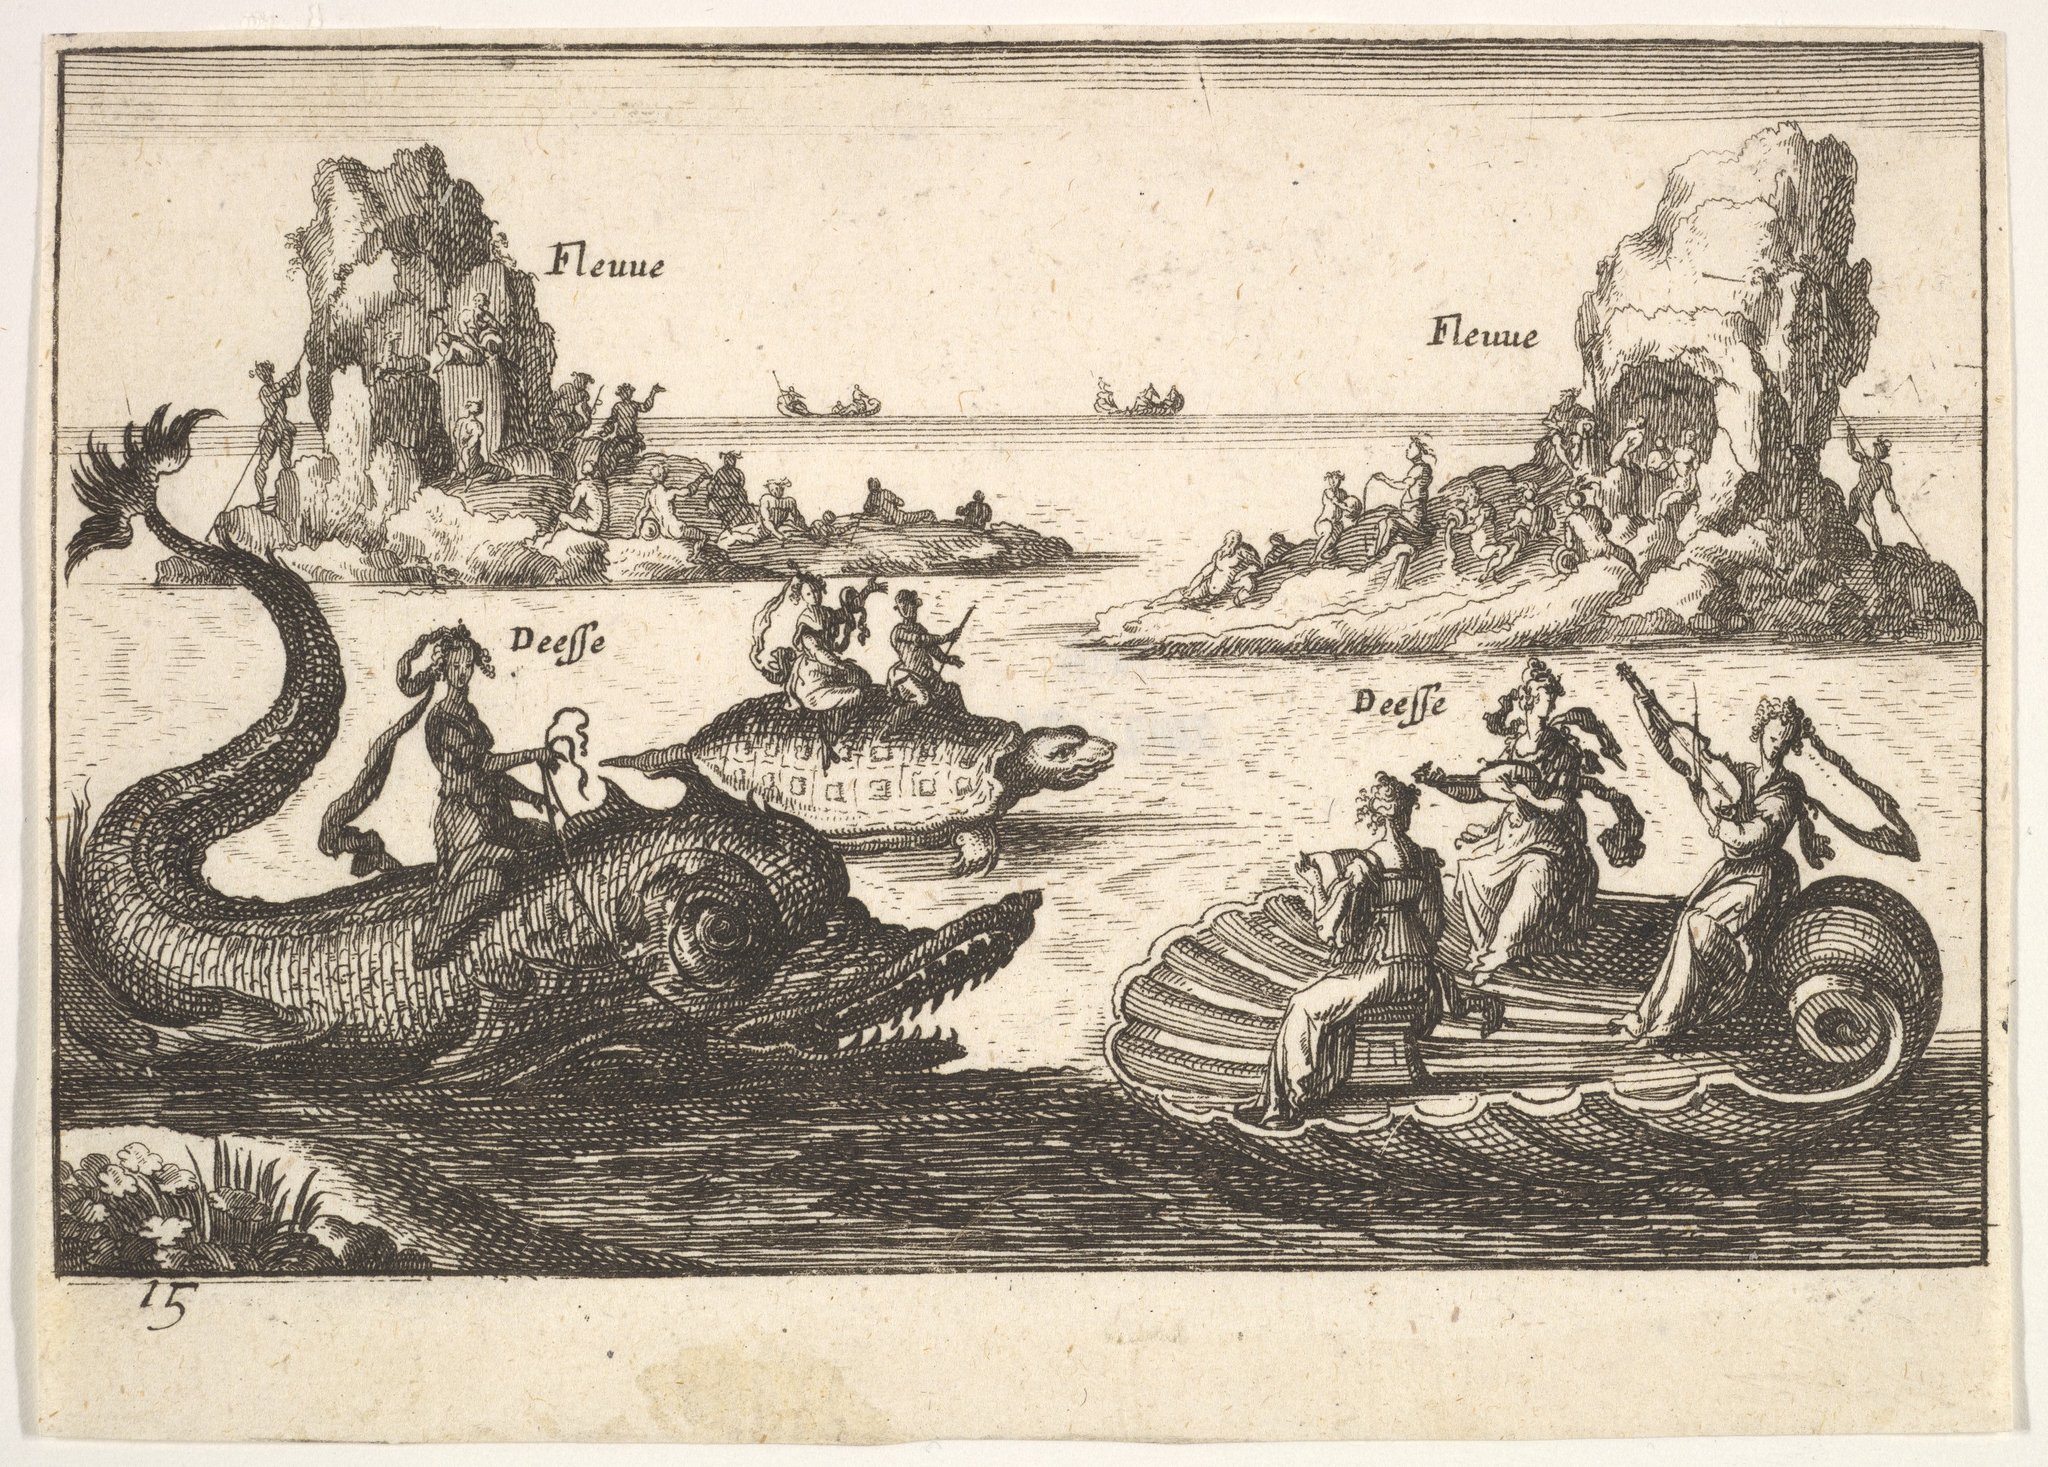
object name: print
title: Plate 15: Rivers and goddesses, with floating islands, from "The magnificent pageant on the river Arno in Florence for the marriage of the Grand Duke" (Le Magnifique carousel fait sur le fleuve de l'Arne a Florence, pour le mariage du Grand Duc)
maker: Anonymous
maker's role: artist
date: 1664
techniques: etching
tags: women,rivers,shells,goddess,musicians